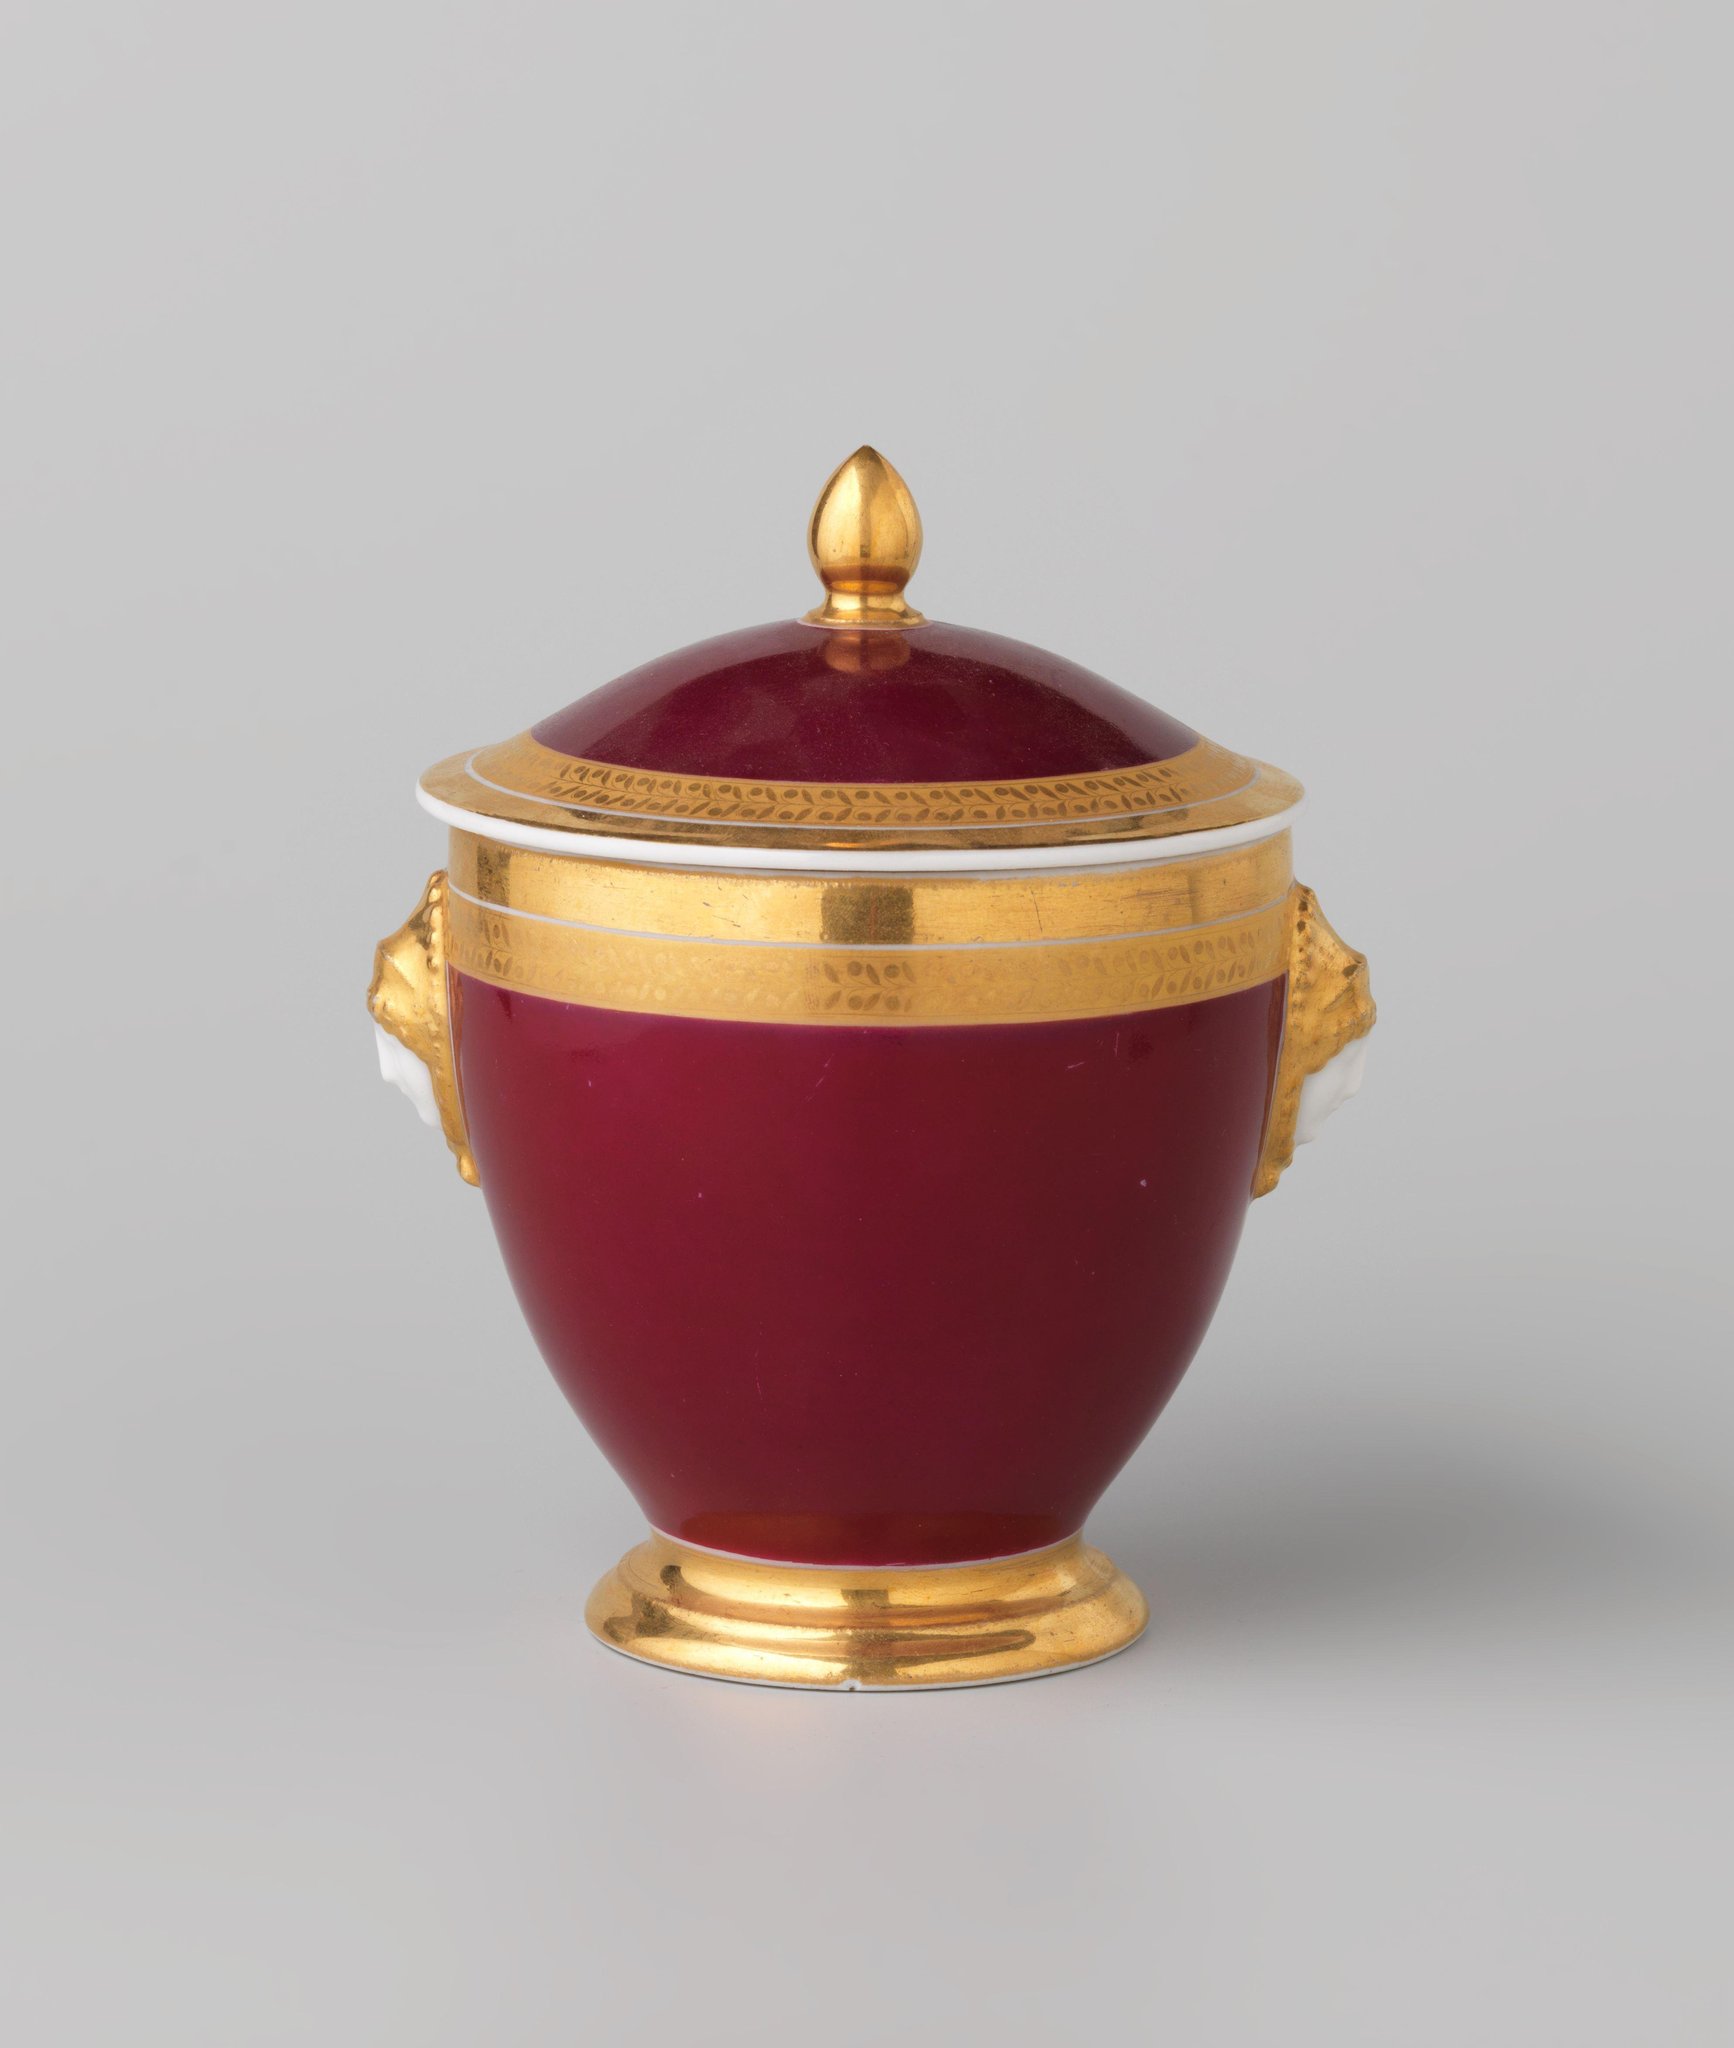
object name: service set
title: Cover of a sugar bowl with gold borders on a red ground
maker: Anonymous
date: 1800-1824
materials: glaze, gold, paint, porcelain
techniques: firing, forming, gilding, turning, vitrification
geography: france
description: Suikerpot van porselein, onderdeel van een koffieservies, lichaam paarsrood, met gouden randen. Aan bovenzijde een brede gouden bies waarin een gegraveerde bladrank. Merken: C,X,11,3 (ingegrift) en de letters SC waarboven een lichtgebogen streep.